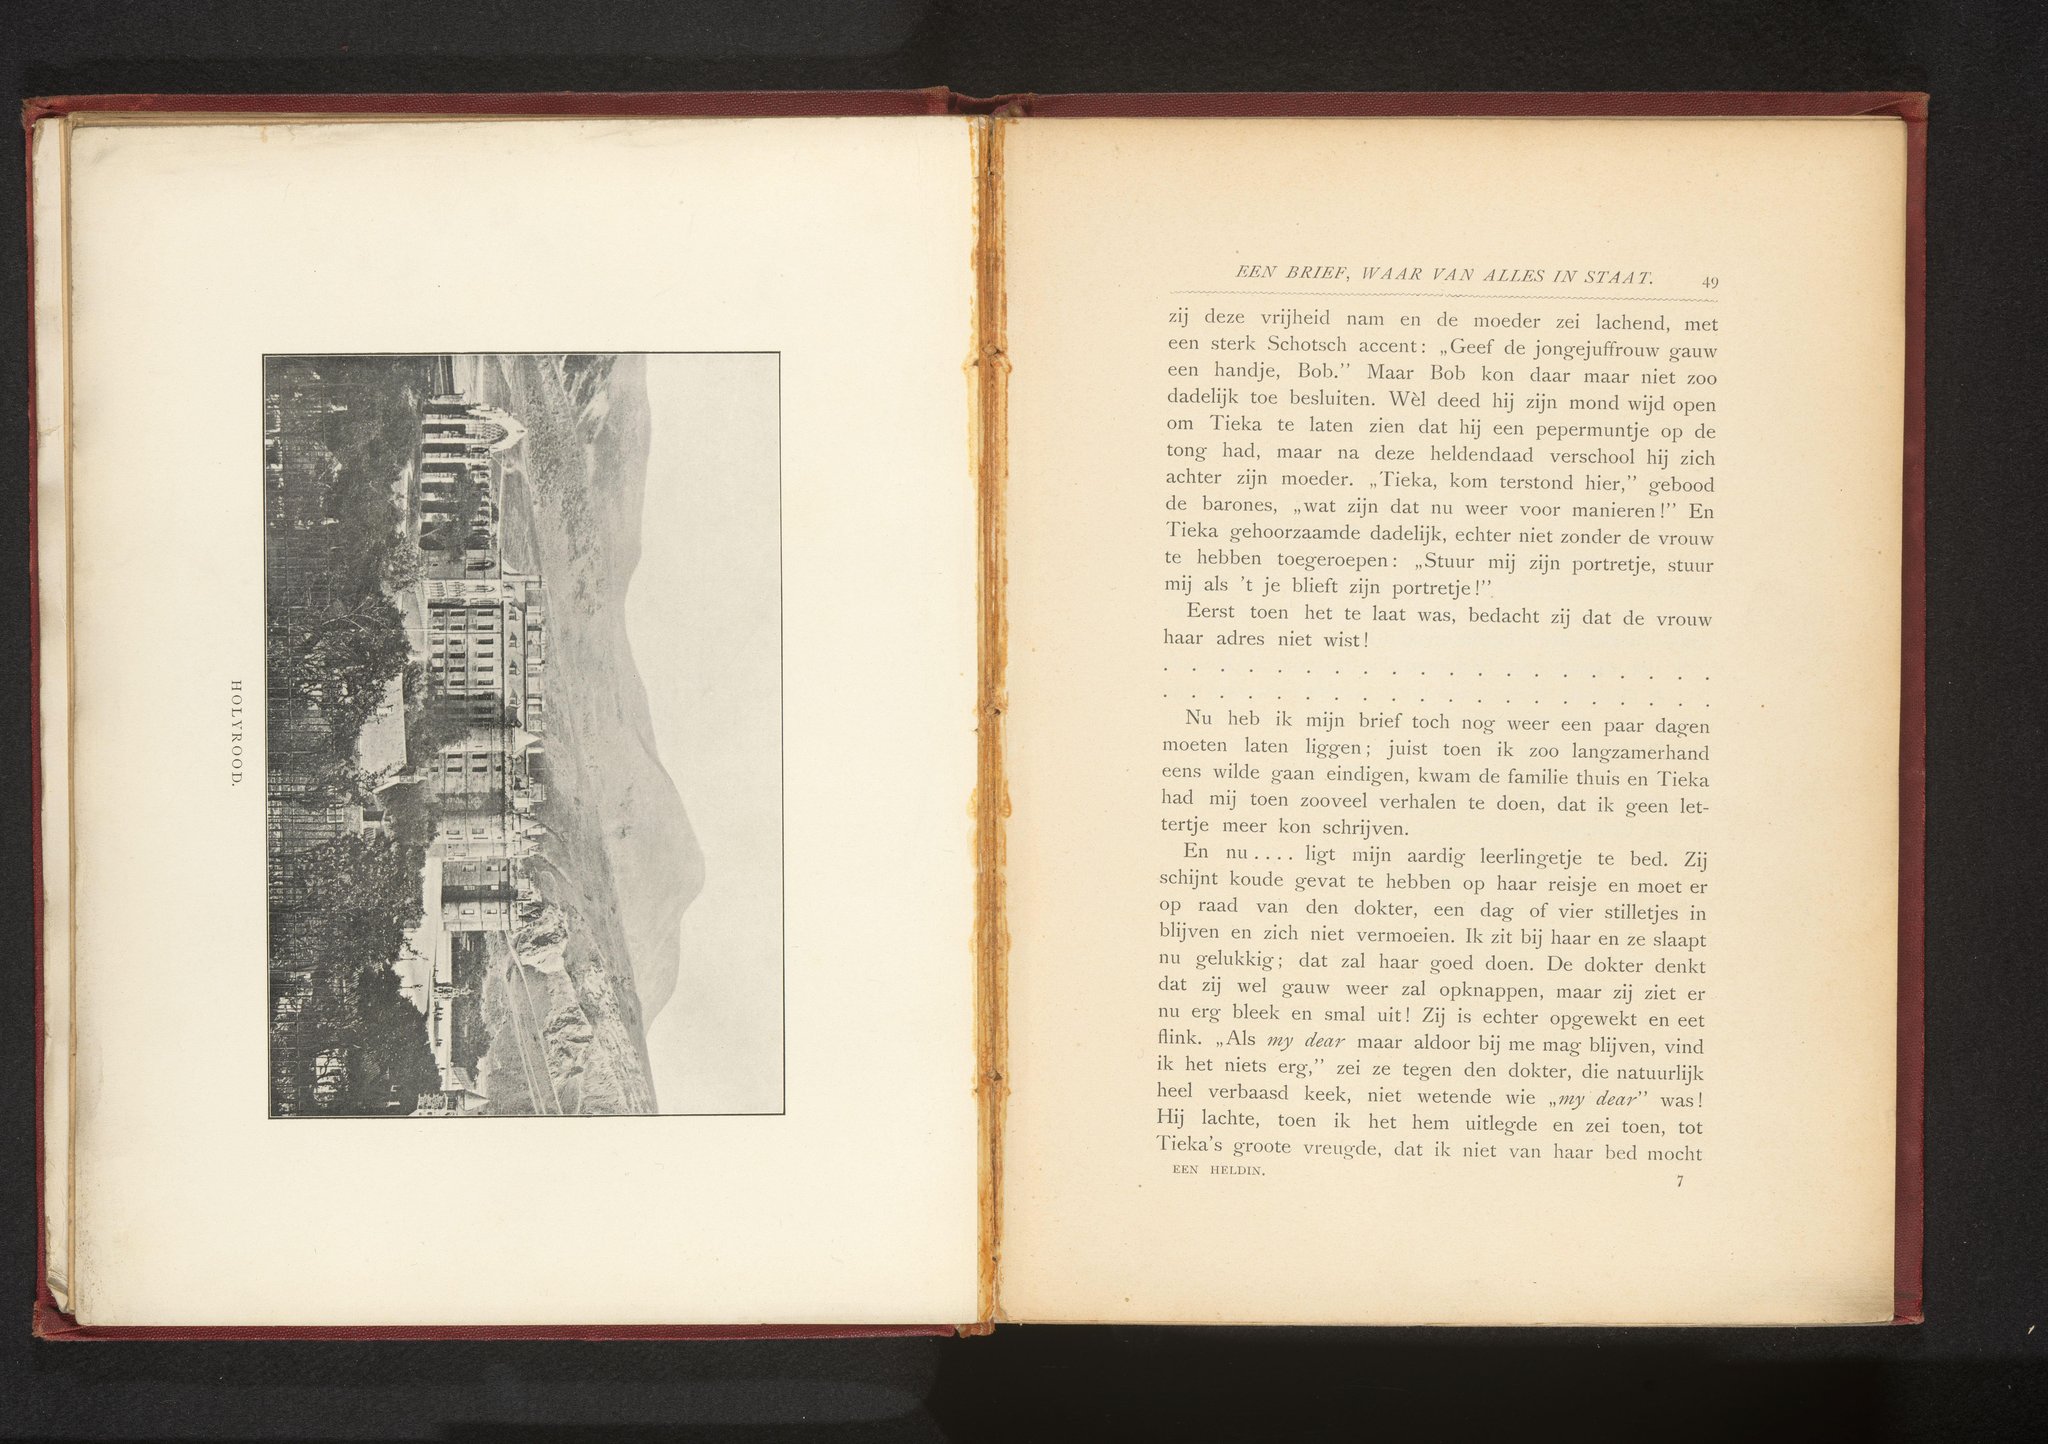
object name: page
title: Gezicht op Holyrood Palace in Edinburgh, Schotland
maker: Anonymous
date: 1901-1906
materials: paper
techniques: autotype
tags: palace